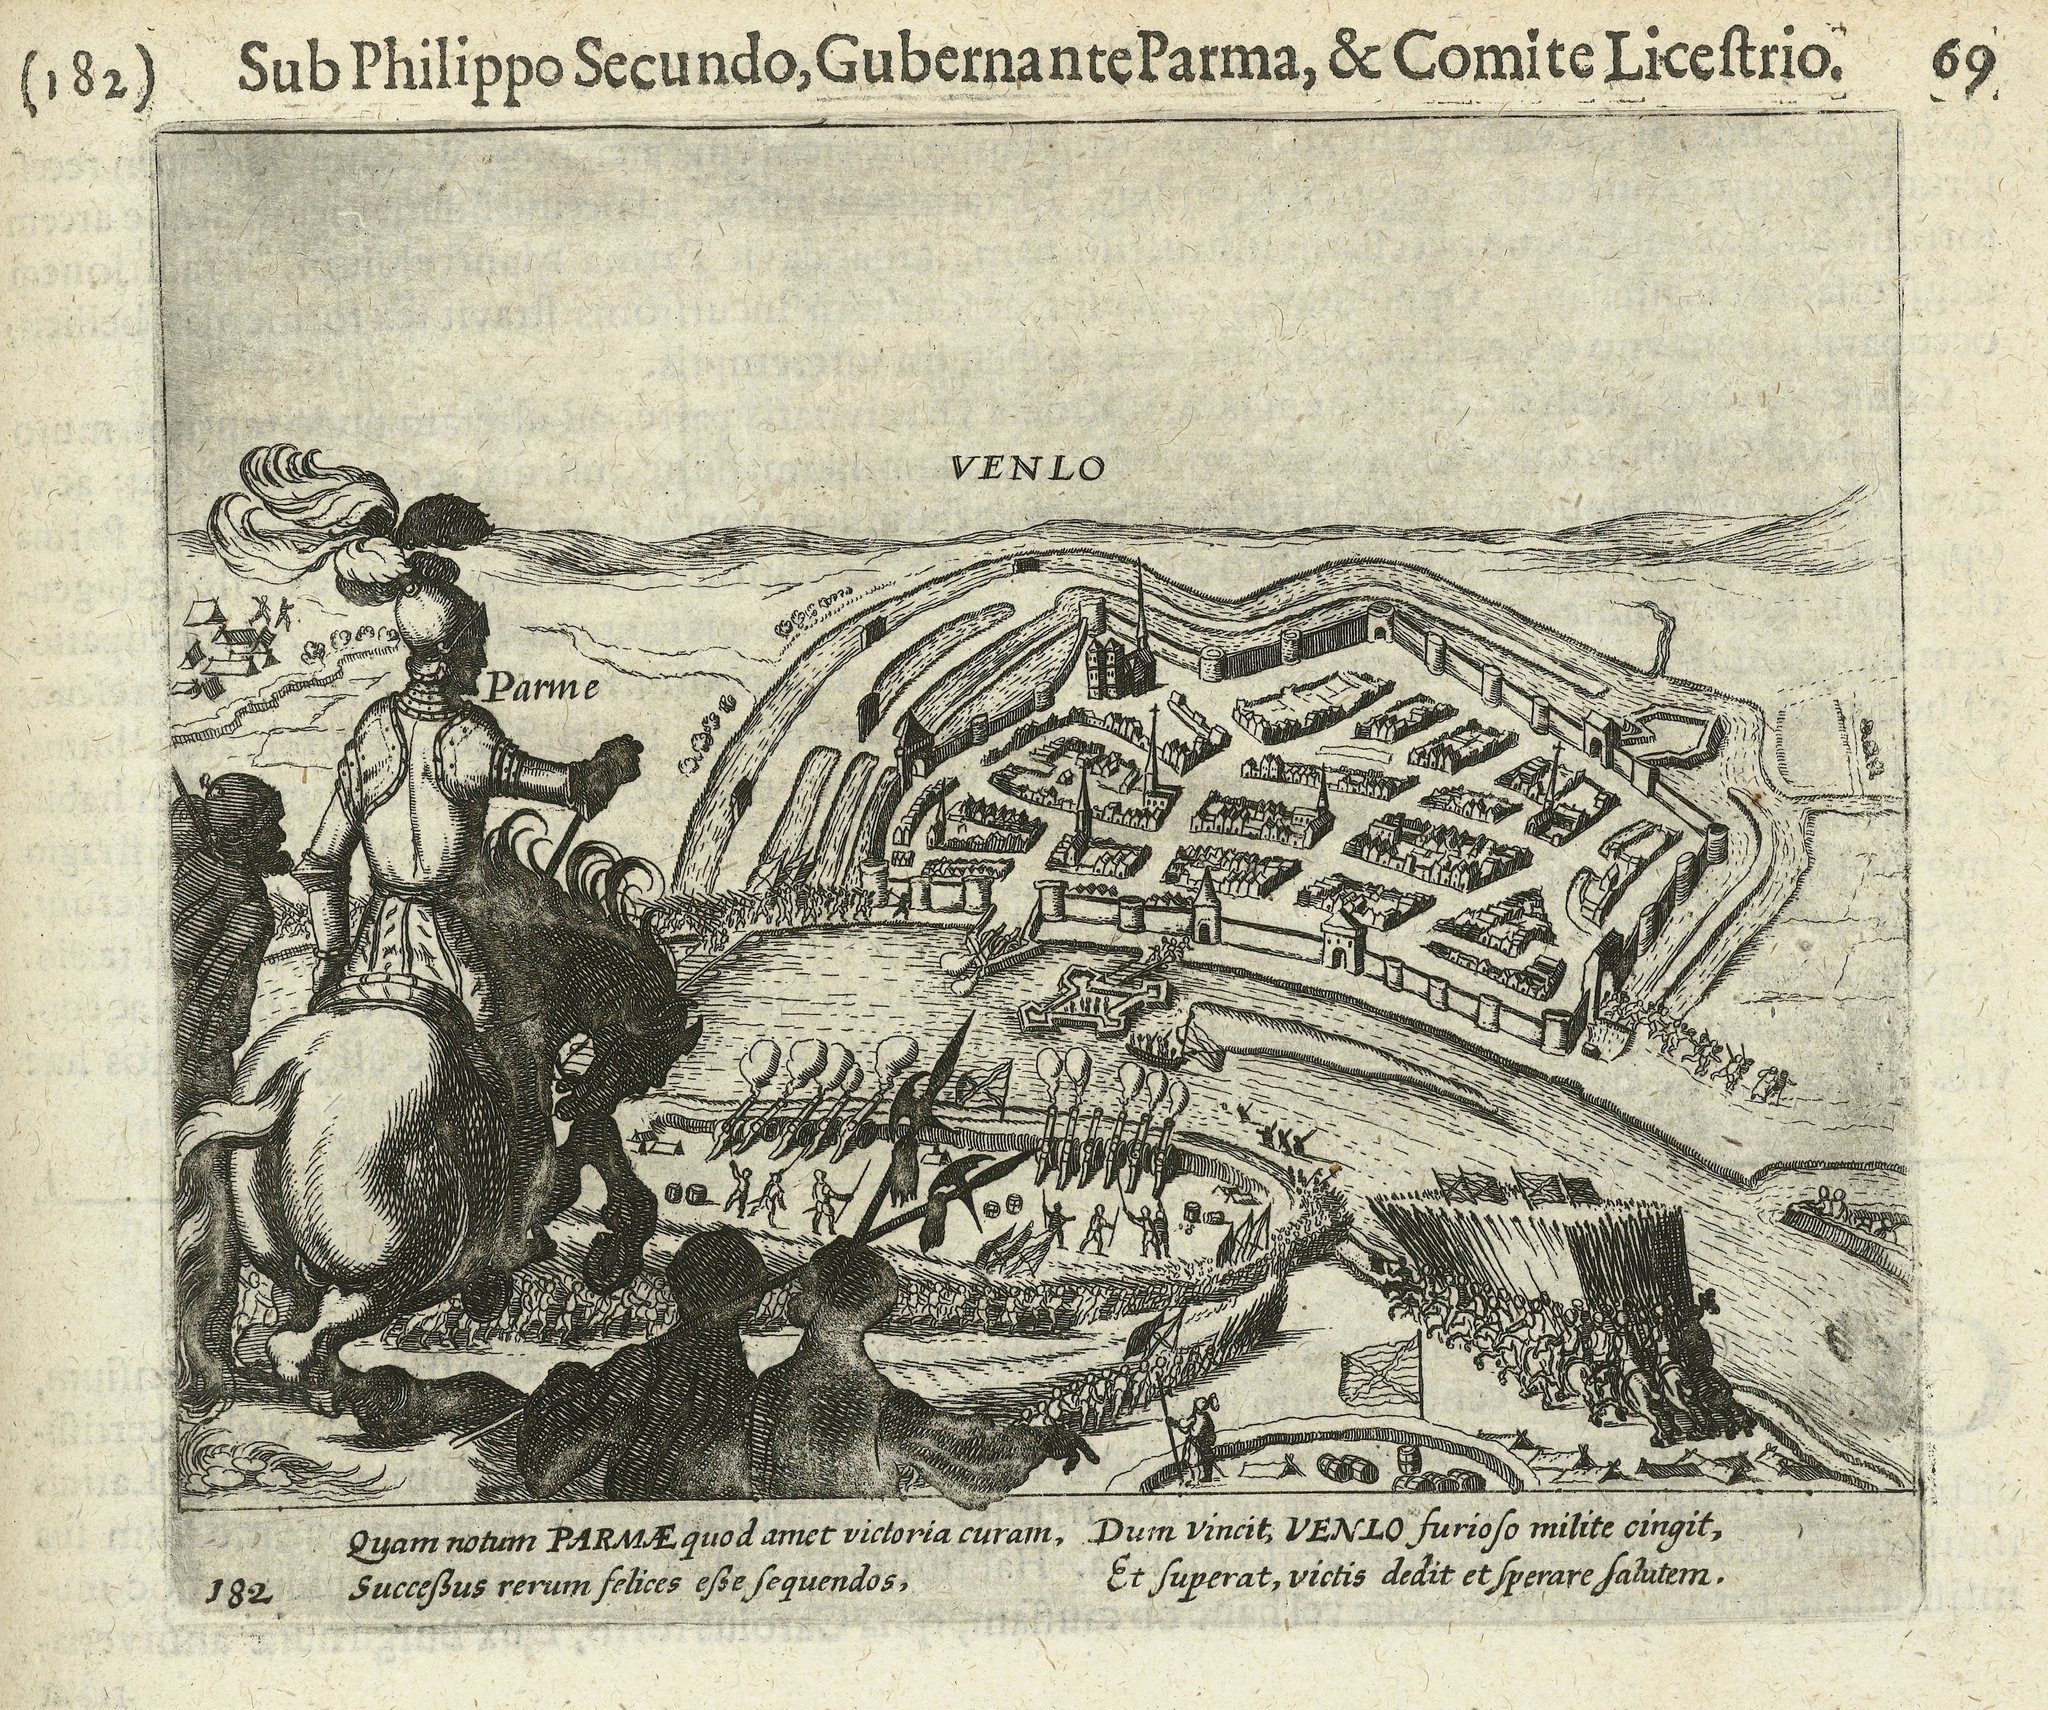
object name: print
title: Beleg van Venlo door de hertog van Parma, 1586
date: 1613-1615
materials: paper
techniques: etching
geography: amsterdam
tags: rome, alessandro farnese (landvoogd van de nederlanden en hertog van parma en piacenza), siege, position war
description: Belegering van Venlo door de hertog van Parma, ingenomen op 28 juni 1586. Gezicht op de stad vanuit de positie van de belegerende Spaanse troepen, links vooraan de hertog van Parma te paard. Met onderschrift van 4 regels in het Latijn. Genummerd 182. Bedrukt op achterzijde met tekst in het Latijn.